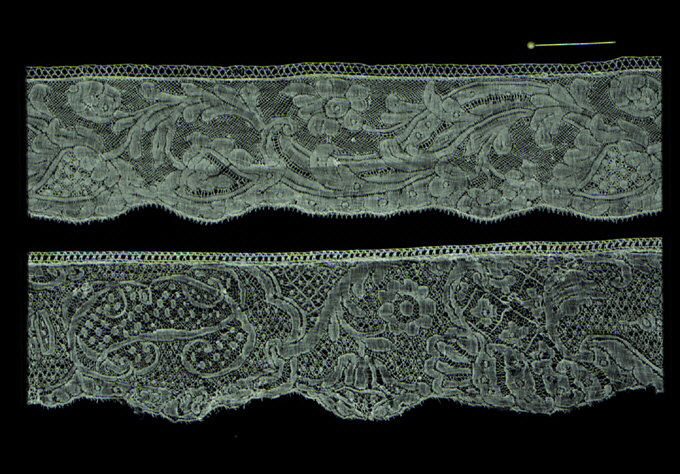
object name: strip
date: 1701-1733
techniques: lace